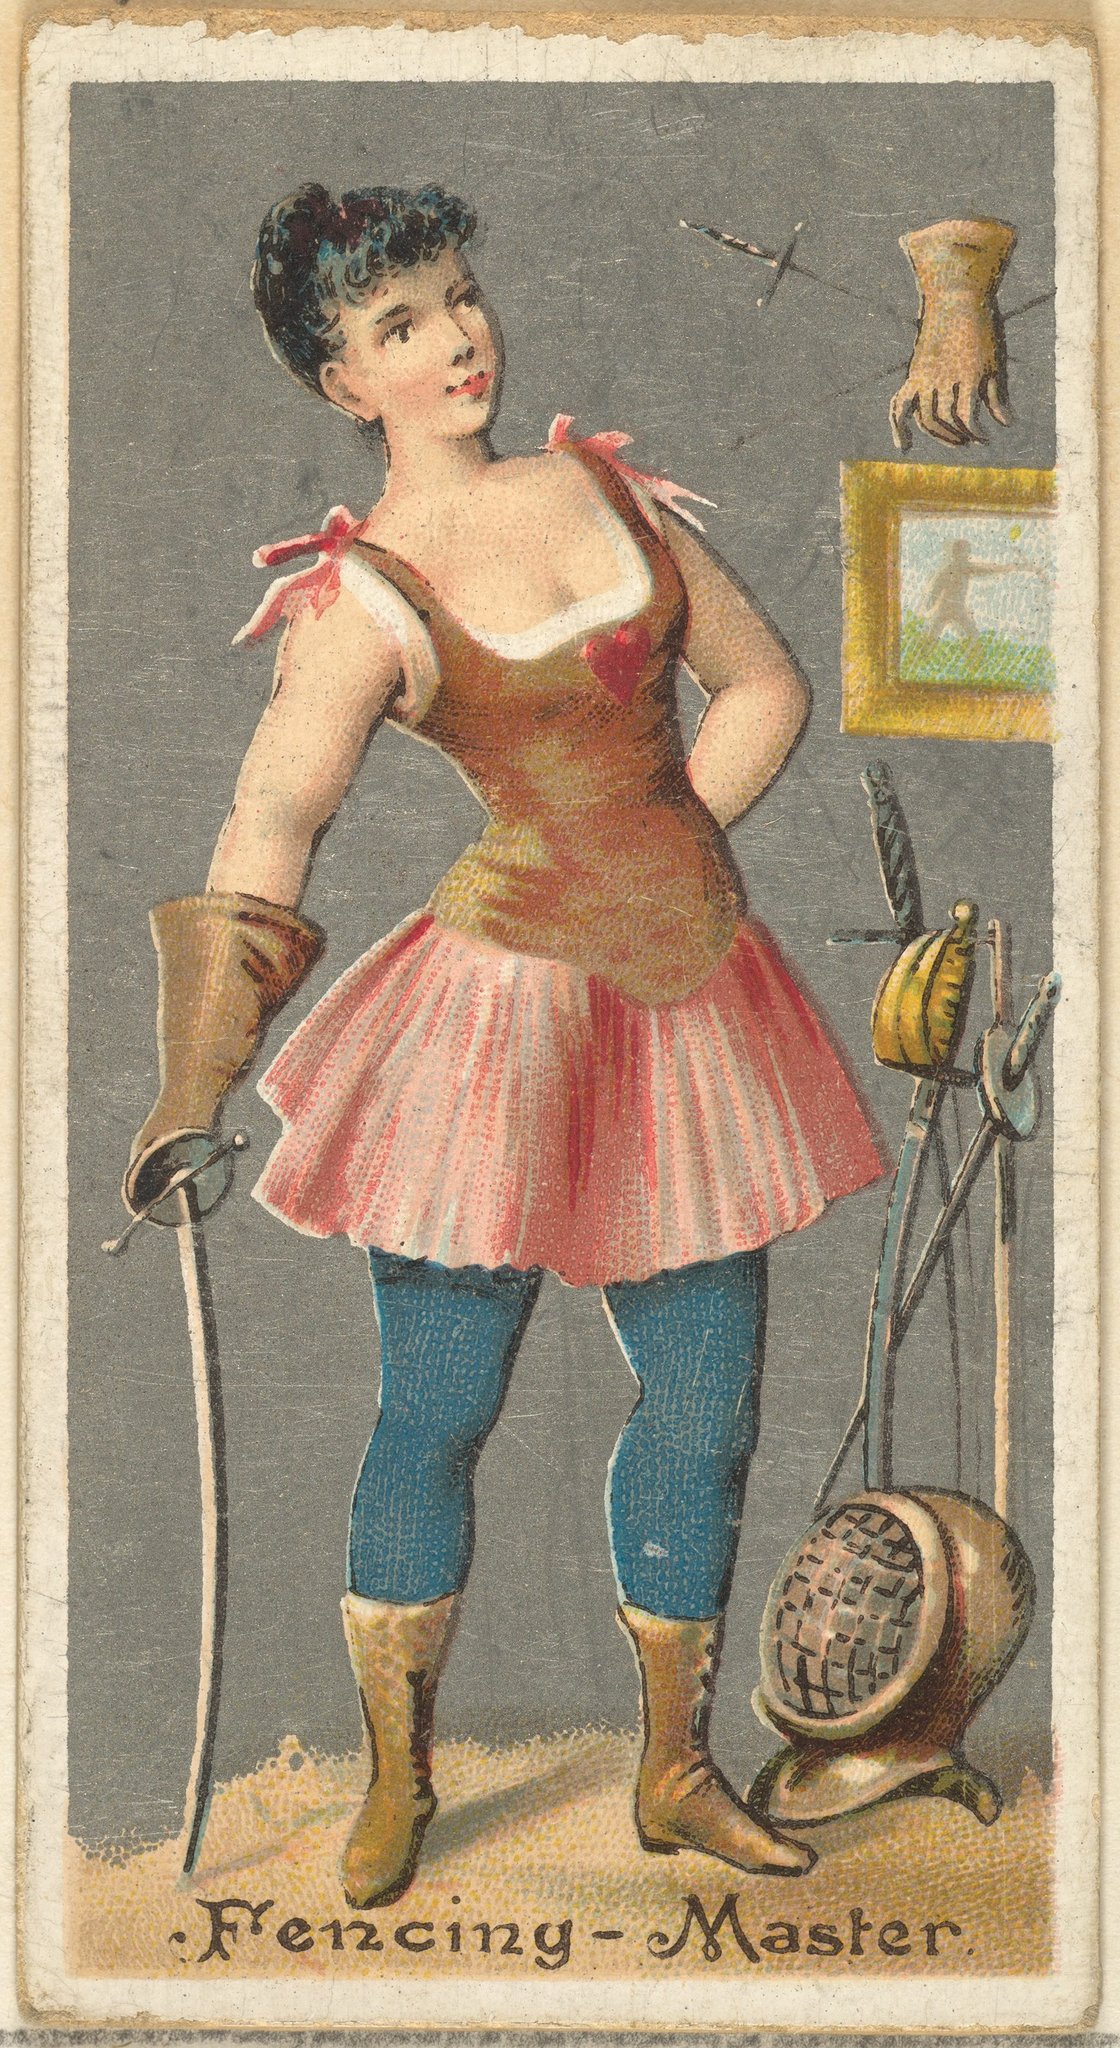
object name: print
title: Fencing - Master, from the Occupations for Women series (N166) for Old Judge and Dogs Head Cigarettes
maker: goodwin & company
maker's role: publisher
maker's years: 1850-1950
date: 1887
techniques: color lithograph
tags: women,fencing